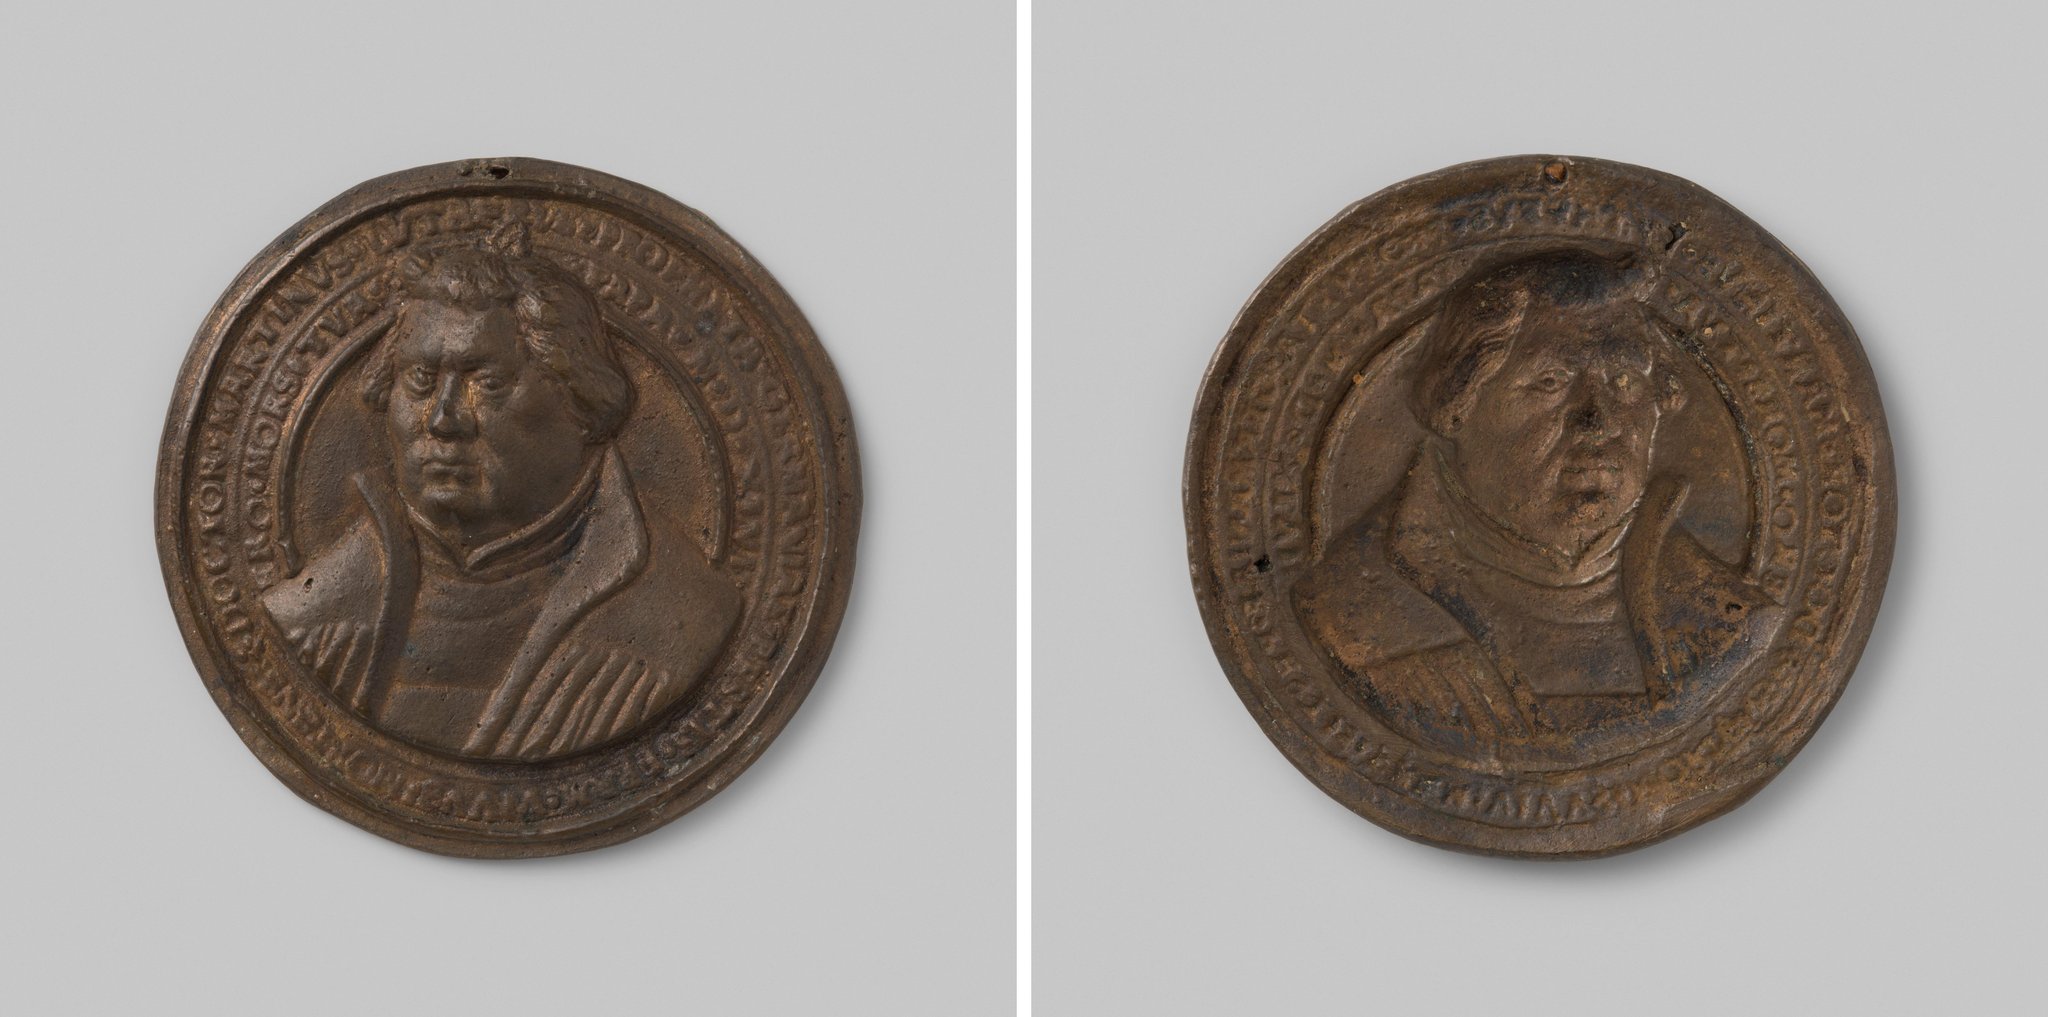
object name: copy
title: Overlijden van Martin Luther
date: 1547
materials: bronze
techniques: casting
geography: germany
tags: priest, martin luther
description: Eenzijdige bronzen penning. Voorzijde: borststuk man binnen tweeregelig omschrift. Keerzijde: blanco